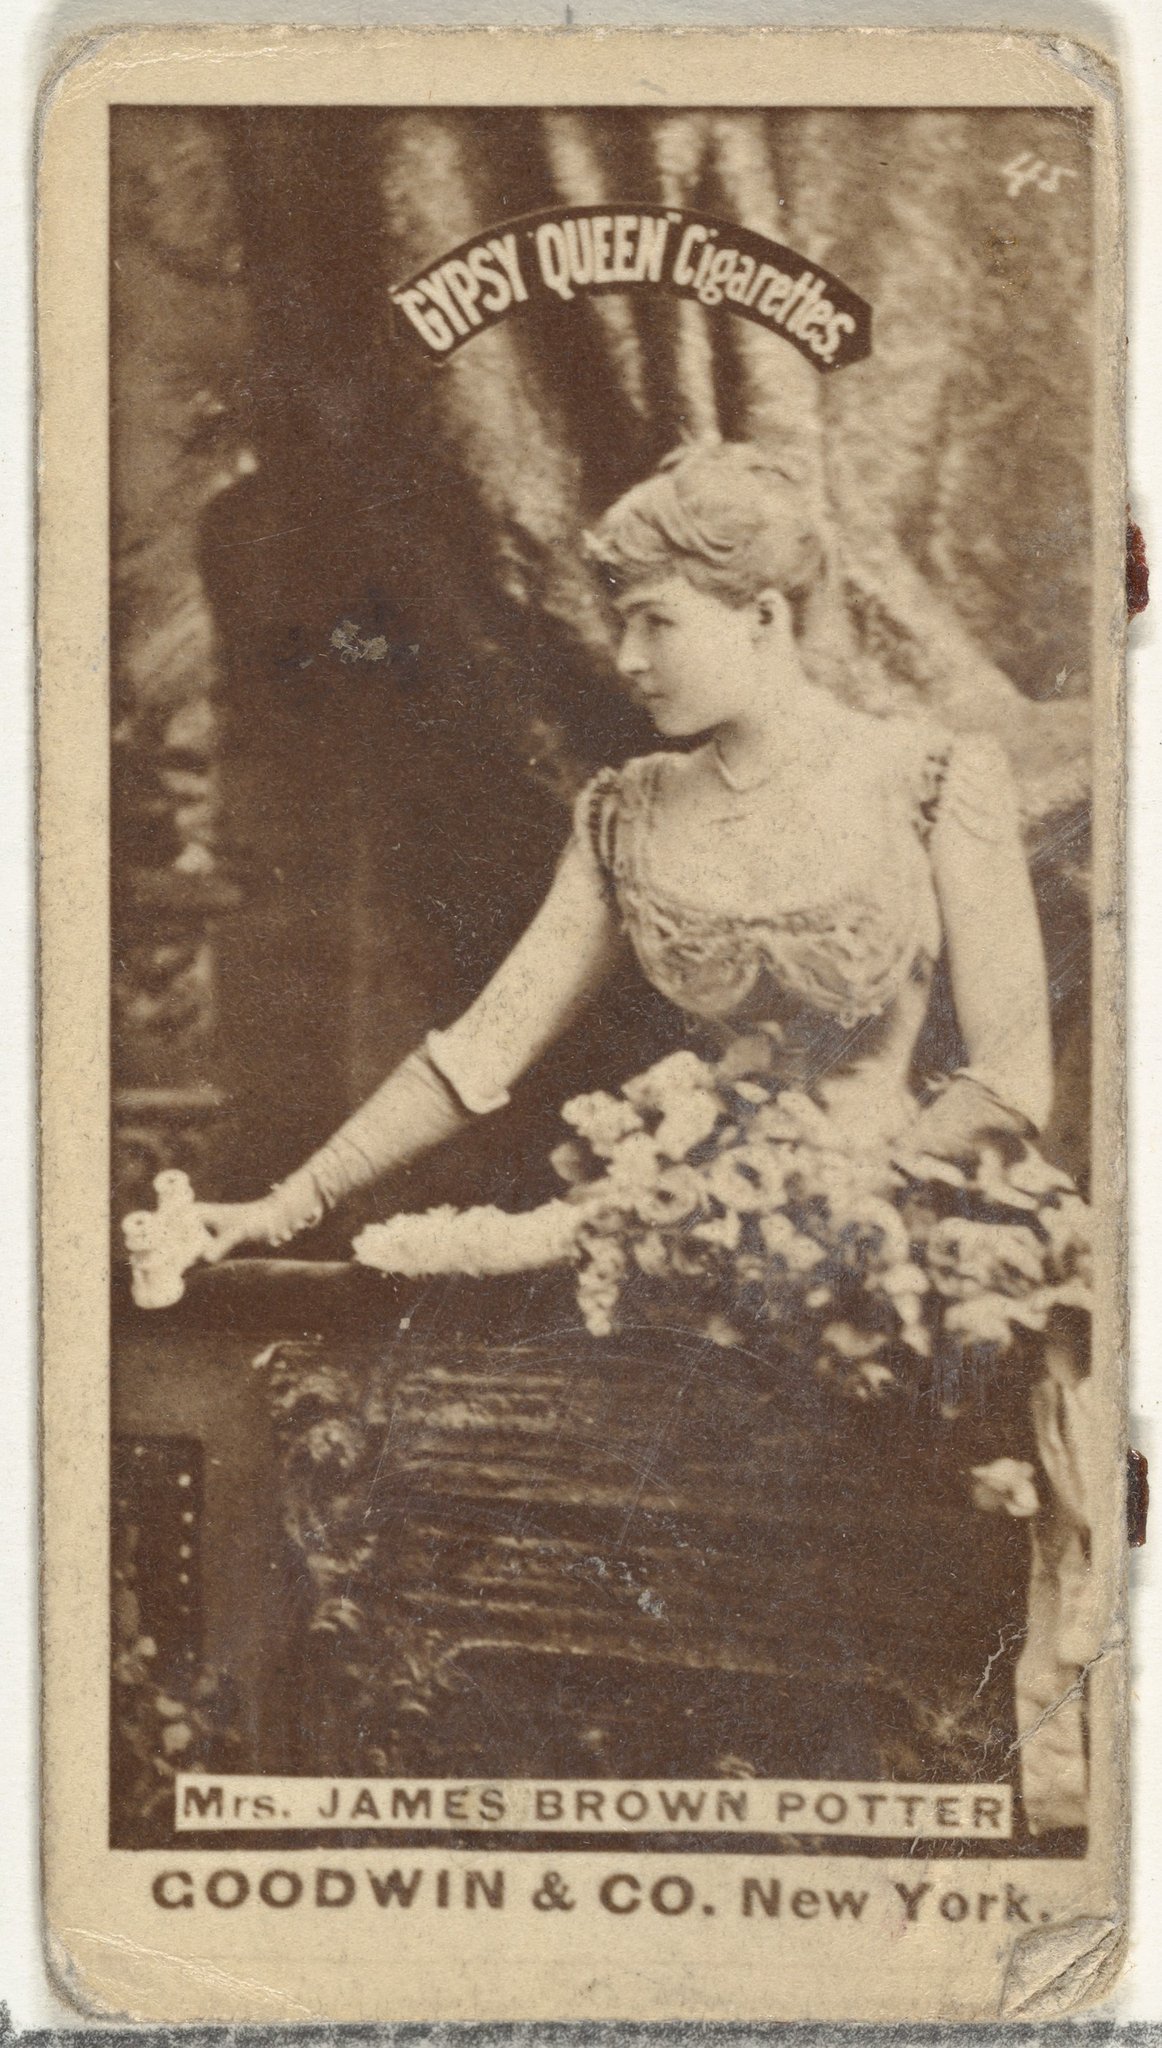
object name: photograph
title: Mrs. James Brown Potter, from the Actors and Actresses series (N171) for Gypsy Queen Cigarettes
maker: goodwin & company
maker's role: publisher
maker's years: 1850-1950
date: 1886-1890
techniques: albumen silver print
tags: portraits,women,actresses